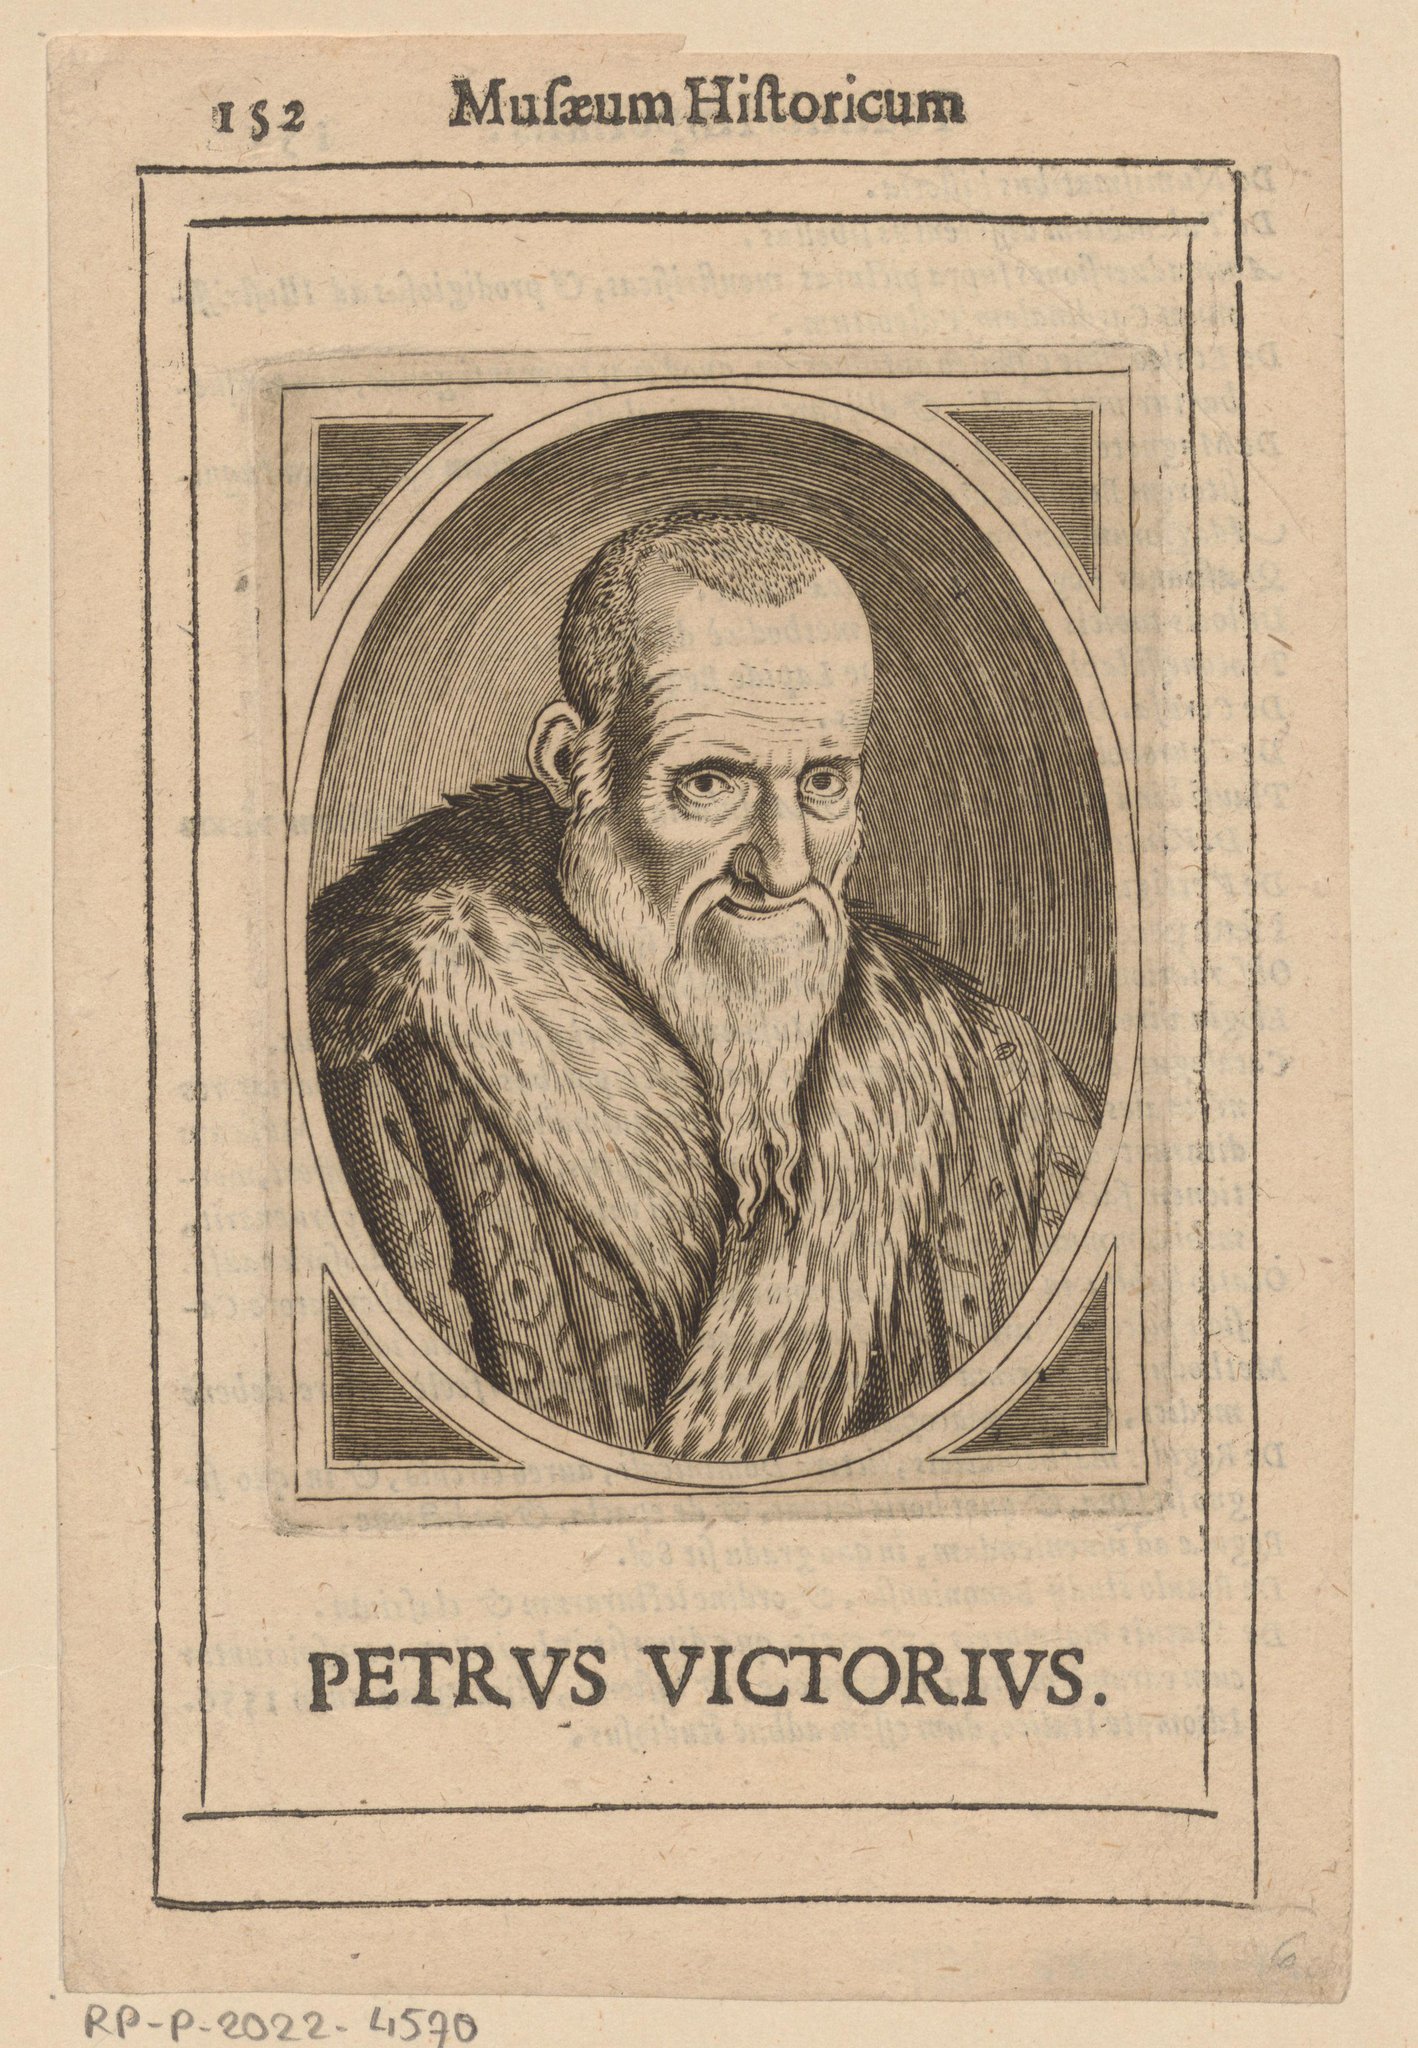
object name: print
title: Portret van Piero Vettòri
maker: Anonymous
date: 1640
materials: paper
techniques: engraving, letterpress printing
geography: venice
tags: scholar, philosopher, historical persons, portrait of a writer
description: Prent uit: Imperiali, Giovanni. Musaeum historicum et physicum (...). Venetië: Giunti, 1640, p. 152.